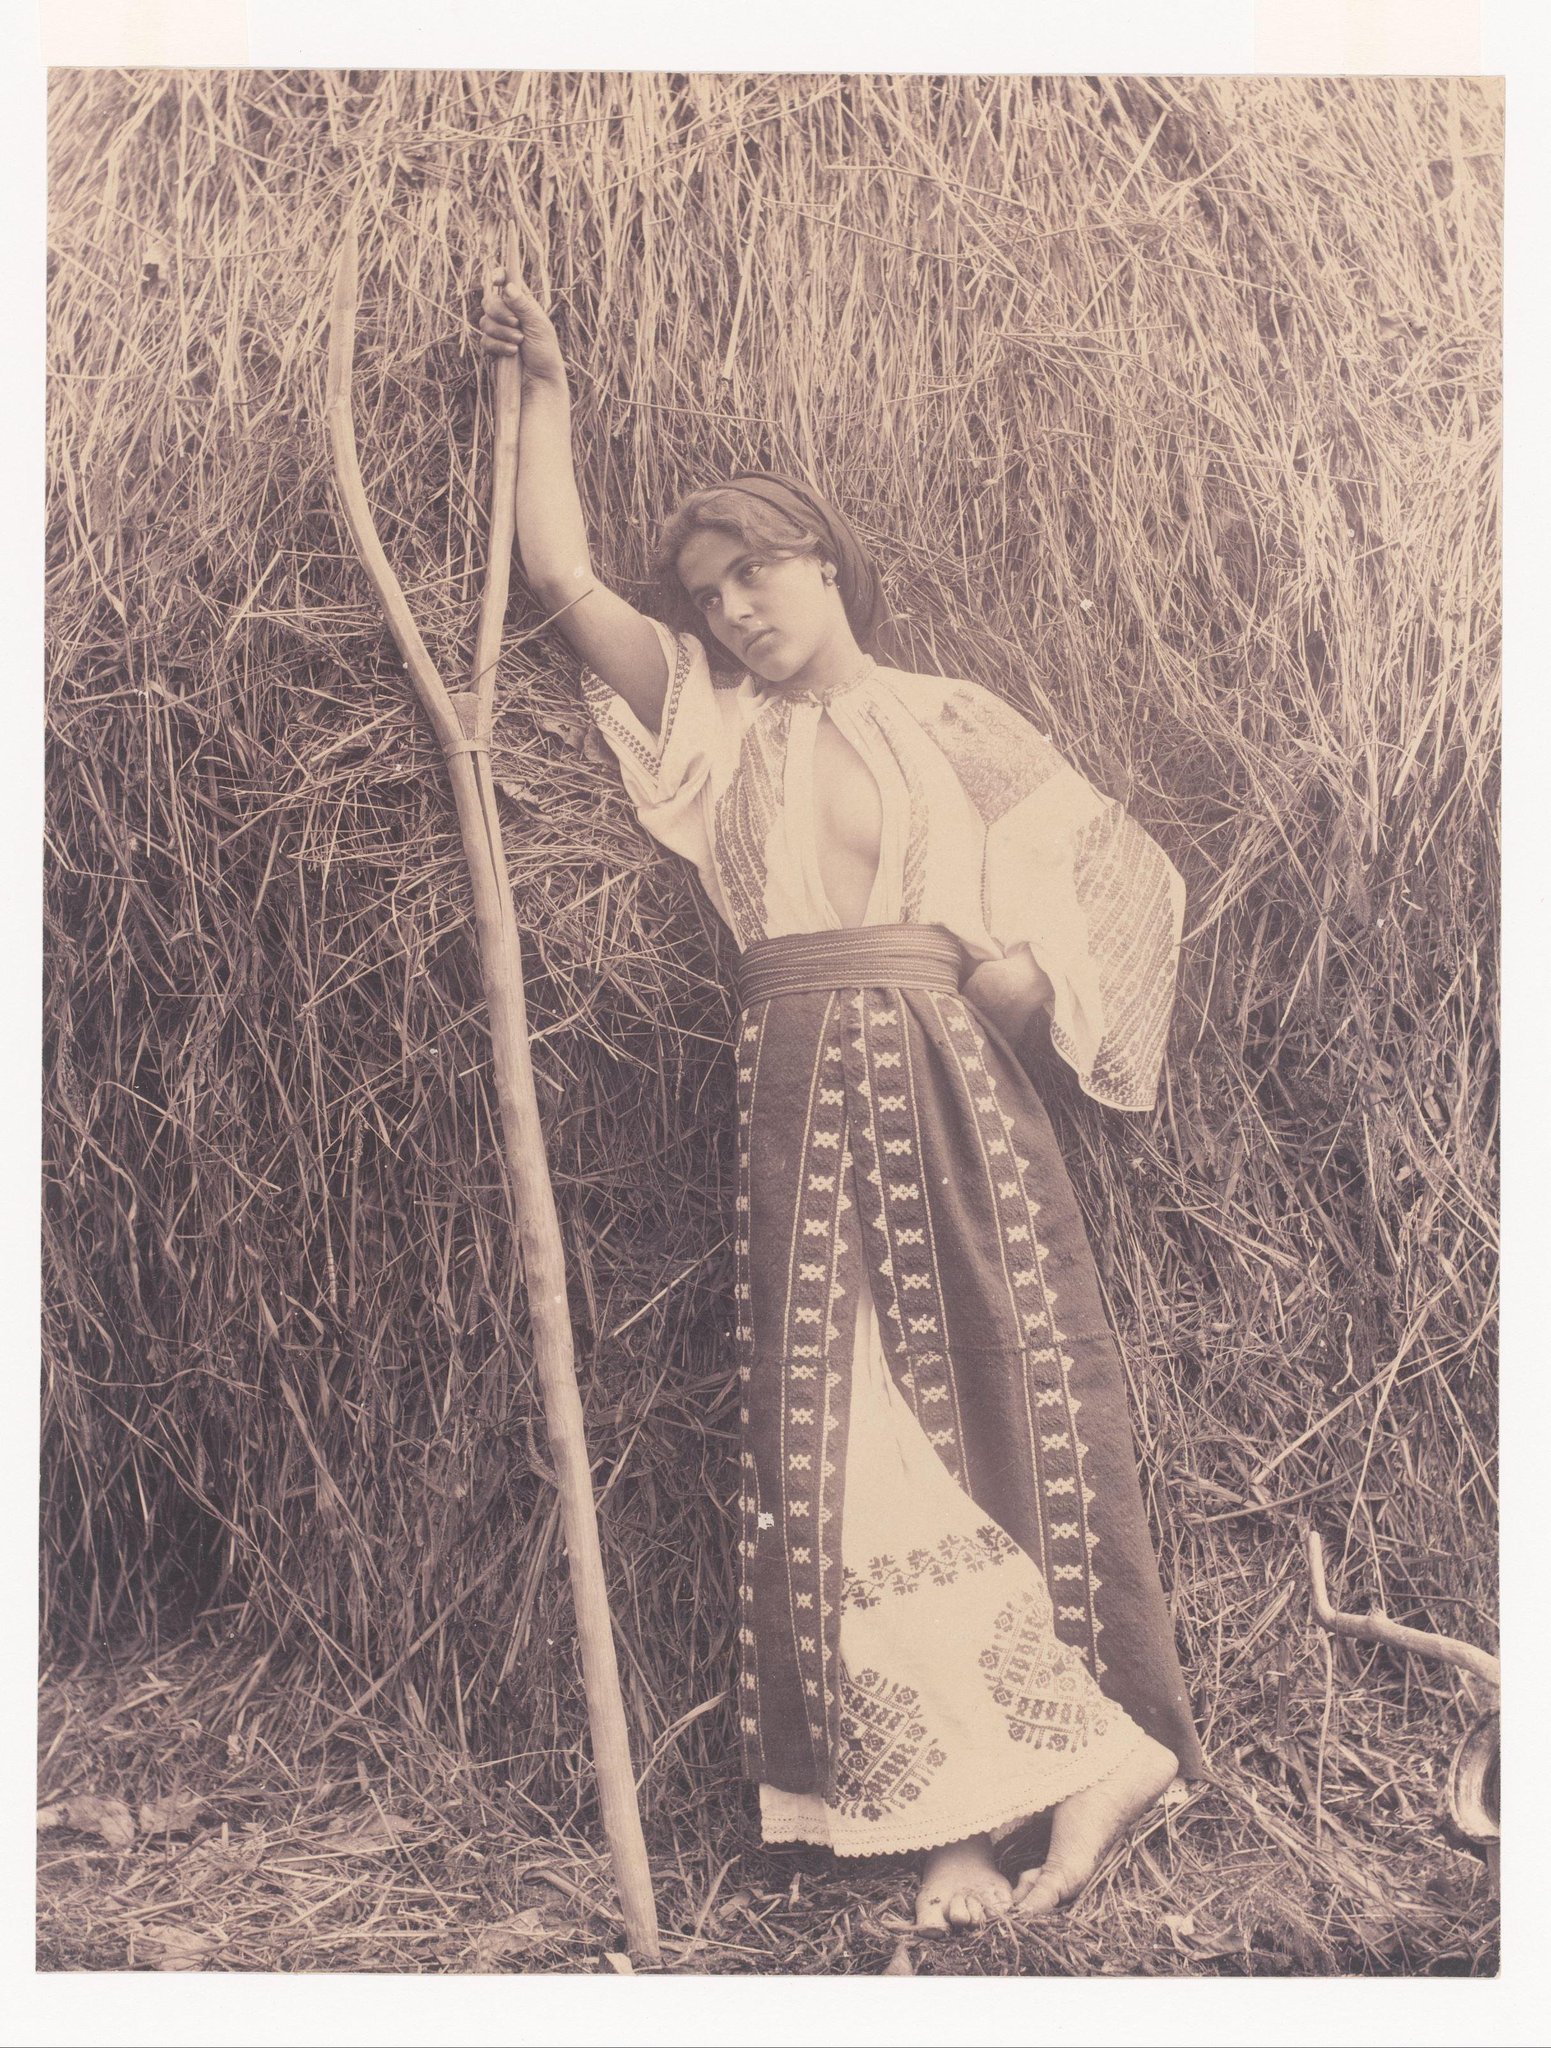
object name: photograph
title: Vrouw met hooivork en open hemd, geleund tegen een hooiberg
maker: Anonymous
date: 1870-1900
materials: cardboard, paper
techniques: albumen print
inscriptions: inscription: ‘ab’, number: ‘74’